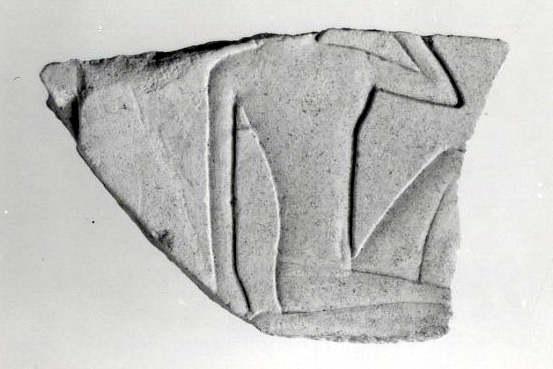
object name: relief fragment, tomb of meketre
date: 1981-1975 BCE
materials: limestone, paint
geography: egypt